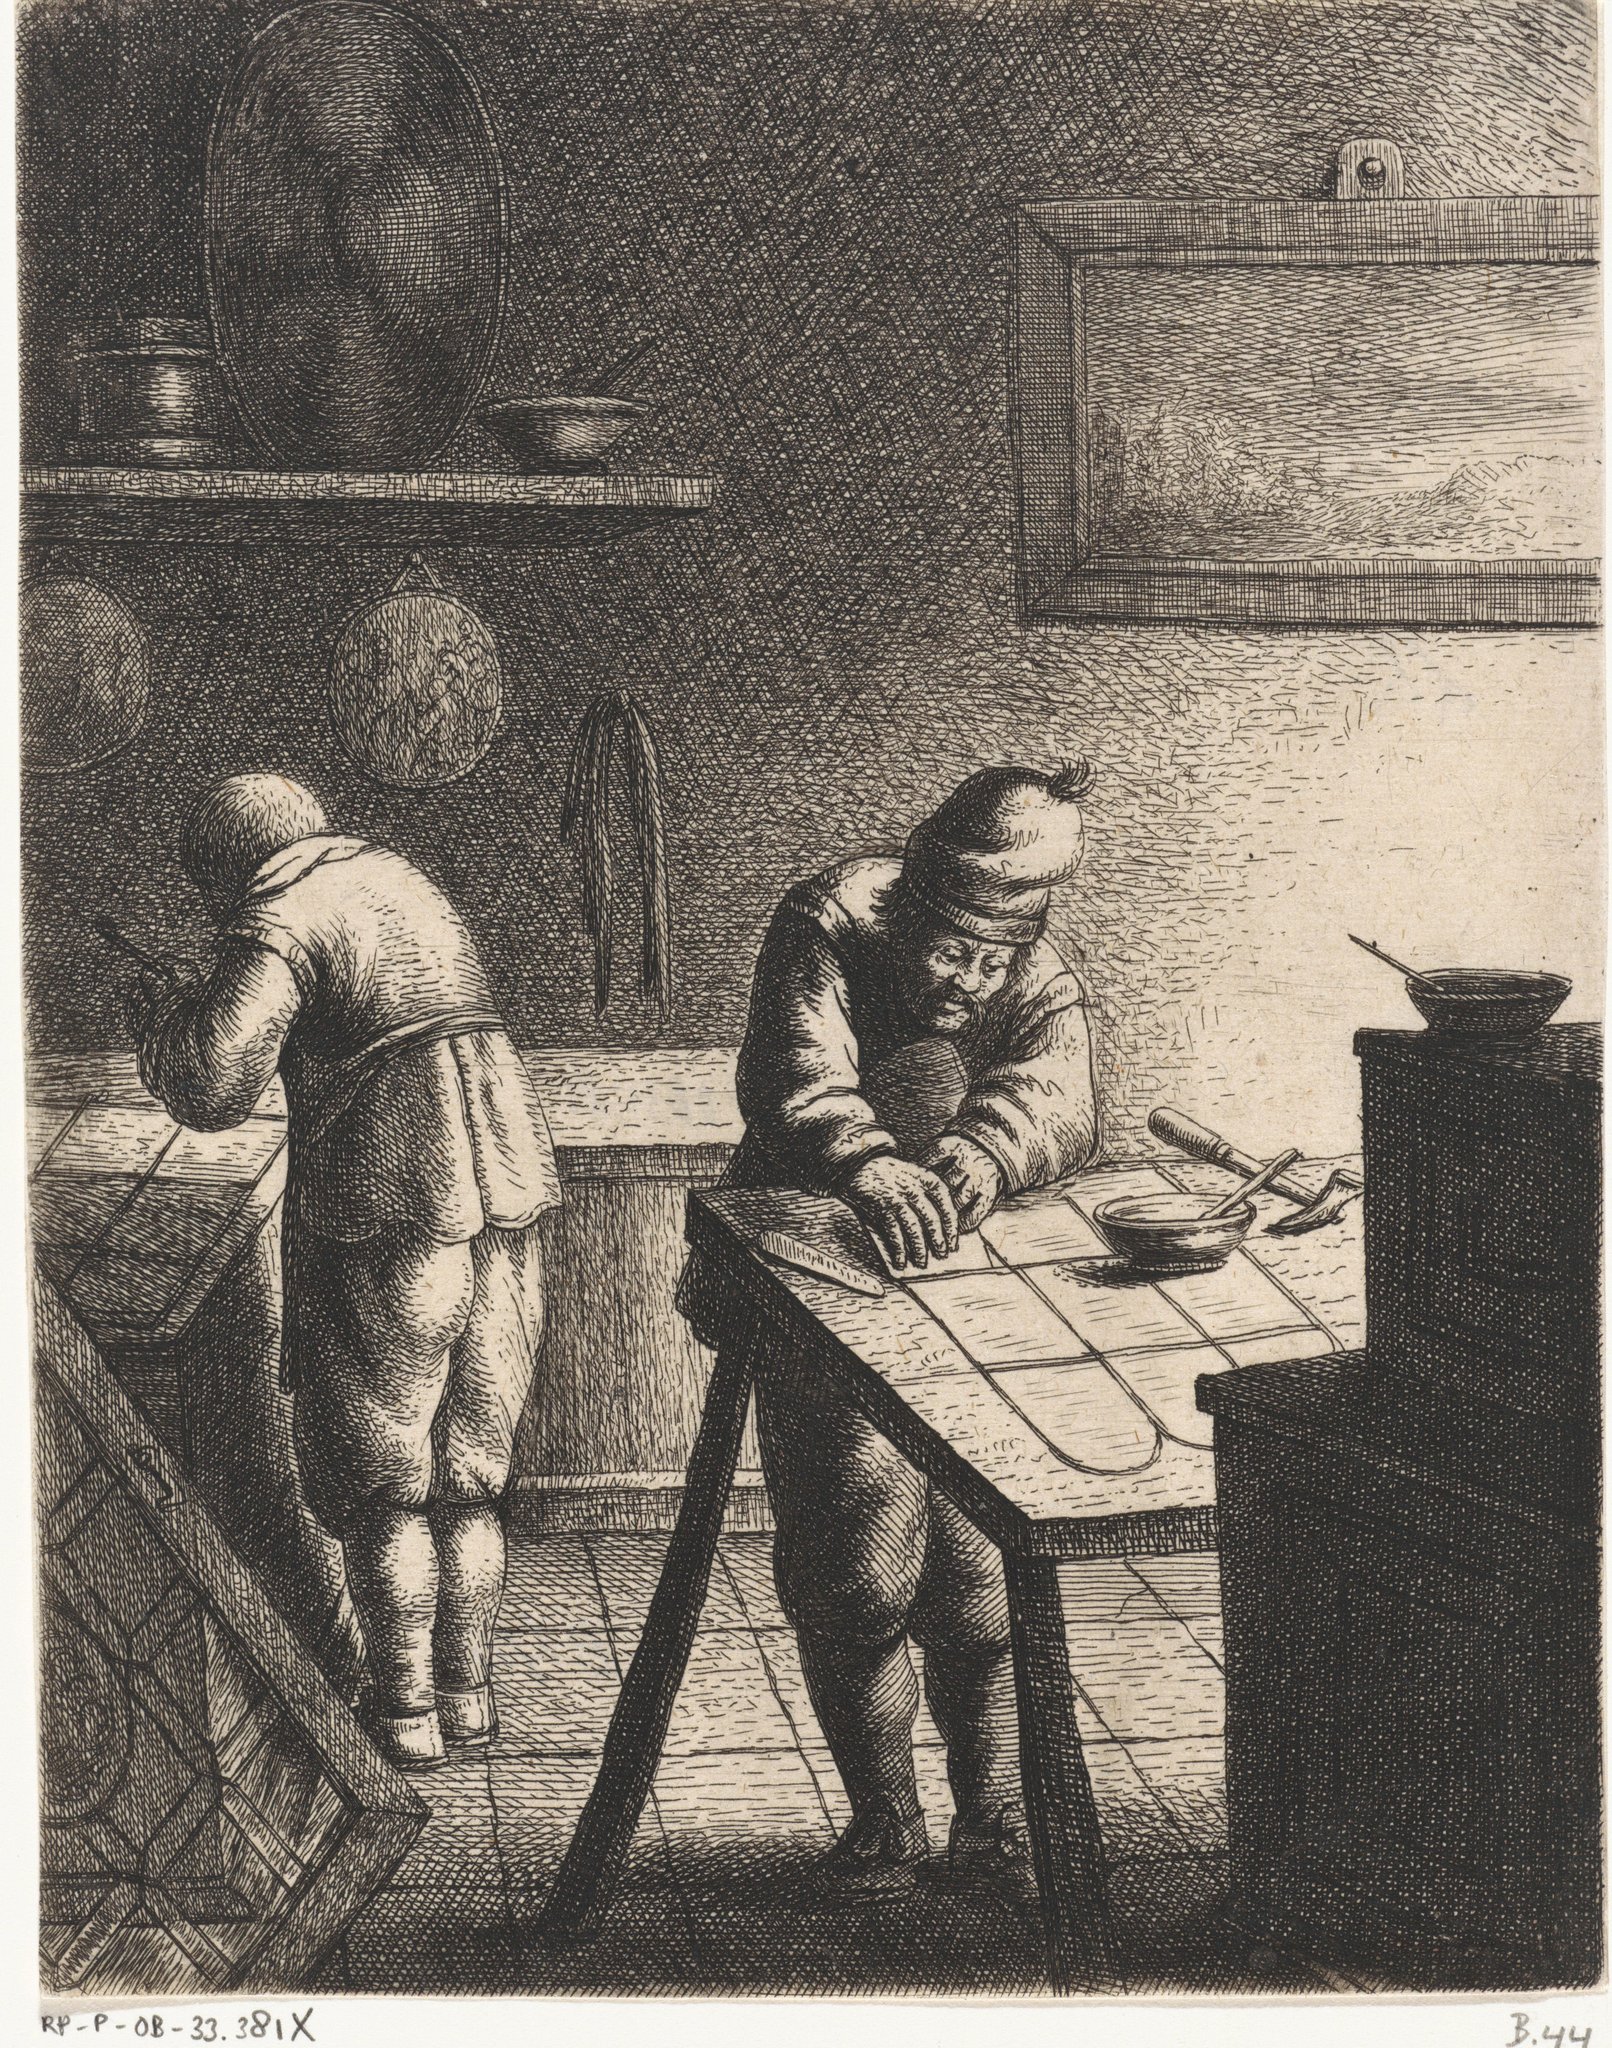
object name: print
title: Beroepen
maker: jan gillisz. van vliet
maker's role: draughtsman, painter, print maker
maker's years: 1600-1668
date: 1635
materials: paper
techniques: etching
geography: leiden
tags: glass-maker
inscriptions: collector's mark: Lugt 240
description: Een man snijdt glas voor een glas-in-loodruit.